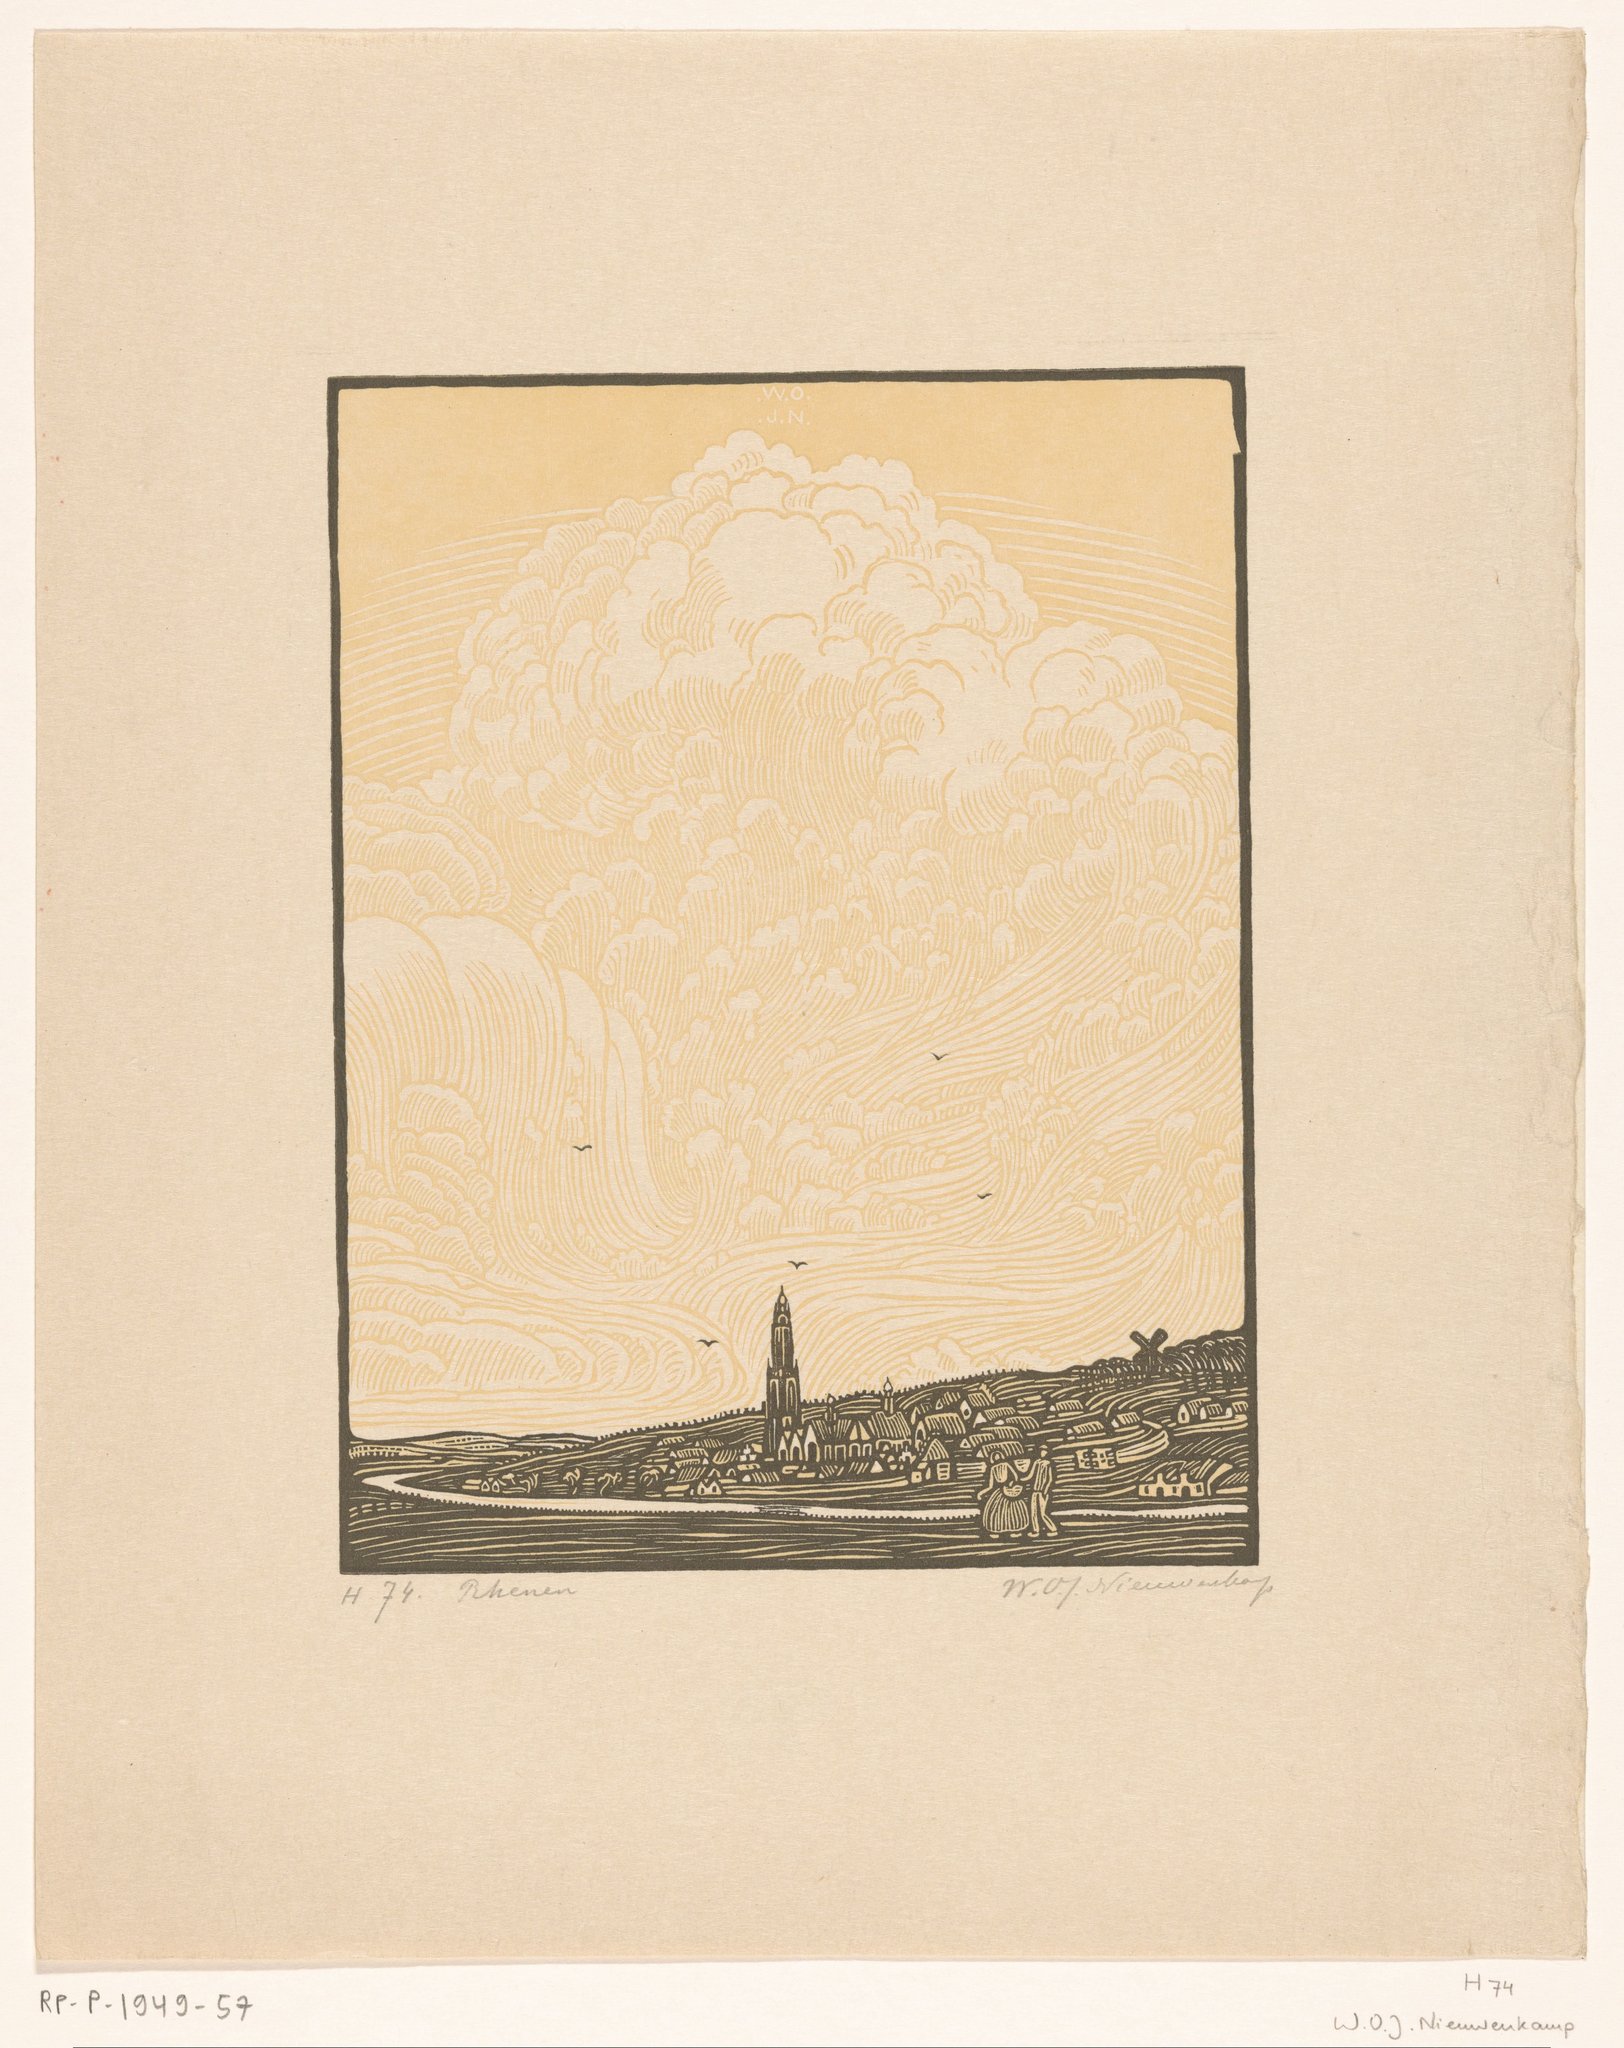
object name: print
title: Rhenen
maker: wijnand otto jan nieuwenkamp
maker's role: draughtsman, print maker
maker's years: 1874-1950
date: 1910-1911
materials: paper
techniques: woodcut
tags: city-view, and landscape with man-made constructions, river, clouds, rhenen, lower rhine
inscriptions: collector's mark: Lugt 2228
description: Een gezicht op Rhenen vanuit de Betuwe. Op de voorgrond een vrouw en een man die wandelen langs de Rijn. Op de achtergrond Rhenen met in het midden de Cuneratoren en rechts de Binnenmolen. Boven de stad wolken.